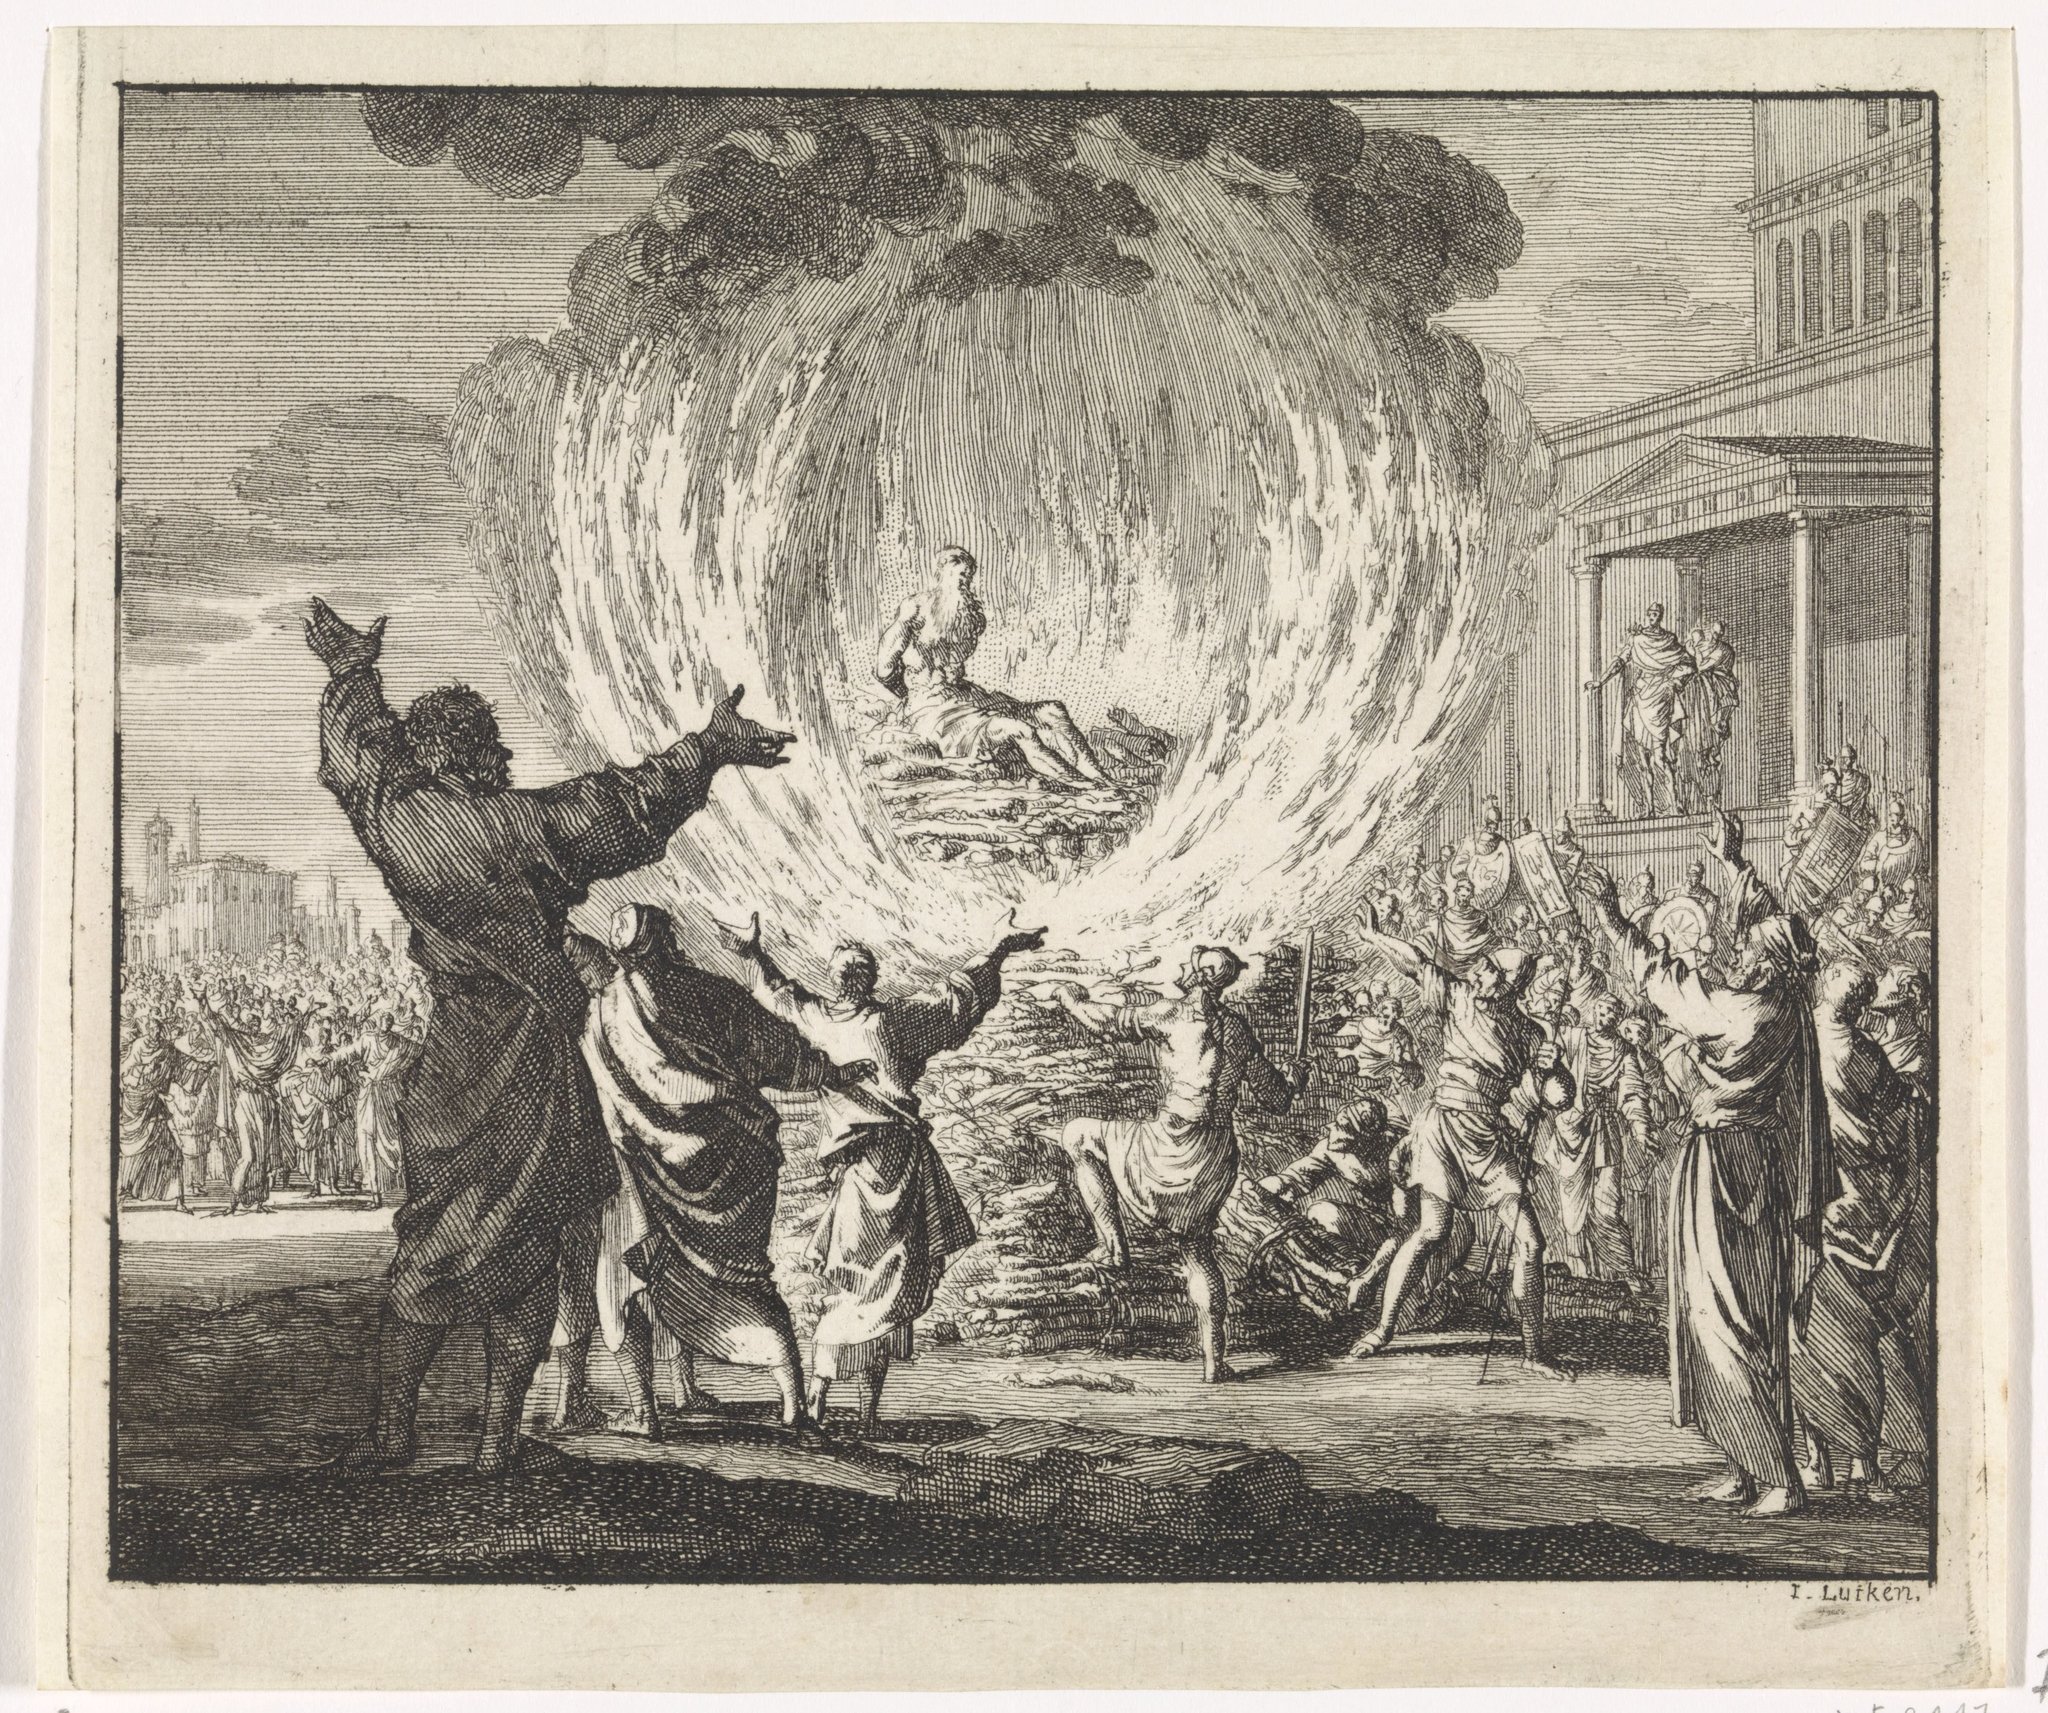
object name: print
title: H. Polycarpus wordt op een brandstapel gezet maar de vlammen verbranden hem niet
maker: jan luyken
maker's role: draughtsman, print maker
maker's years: 1649-1712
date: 1701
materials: paper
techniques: etching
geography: amsterdam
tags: the early christian churches, e.g. armenians, copts, syrians, violent death by burning at the stake; pyre - ee - death not certain; wounded person, male saints (with name)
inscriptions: collector's mark: Lugt 2228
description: Proefdruk van een boekillustratie Arnold, Godfried. Waare afbeelding der eerste christenen. Amsterdam: Jacobus van Hardenberg, Barent Visscher en Jacobus van Nieuweveen, 1700, dl. 2.